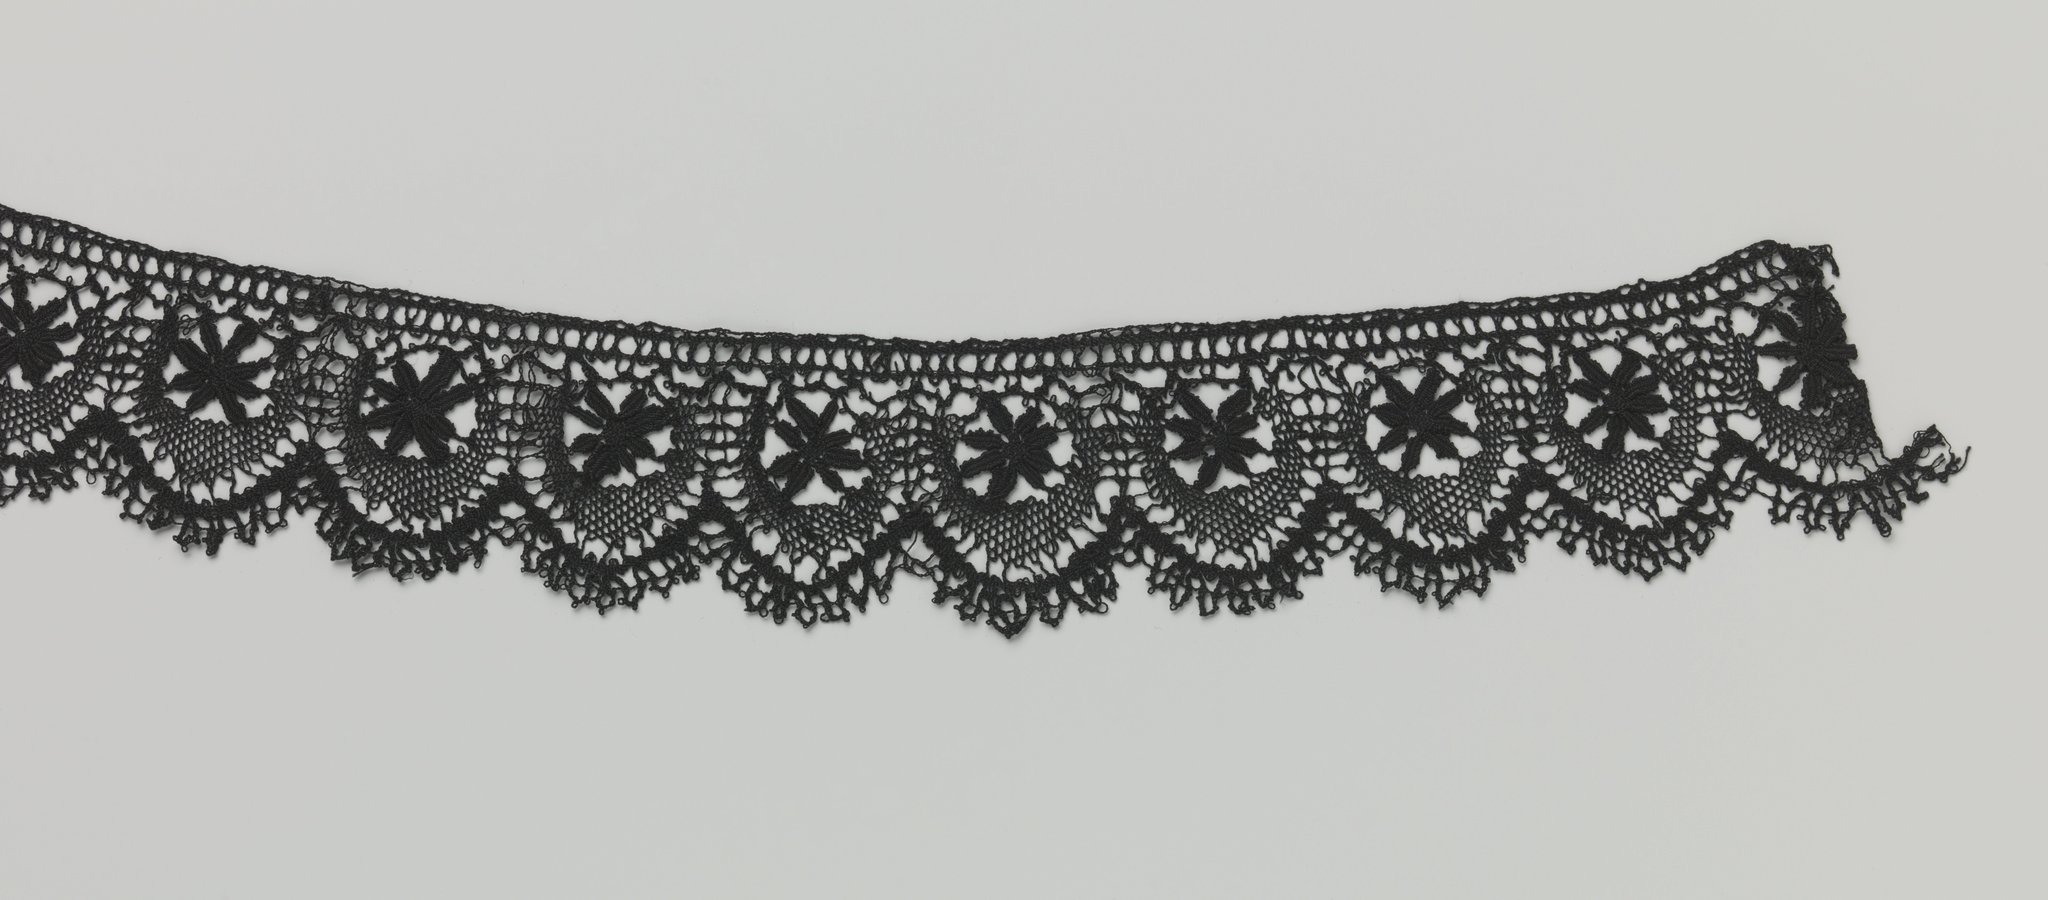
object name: strip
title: Strook kloskant met ster en halve maan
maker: Anonymous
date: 1900-1929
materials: silk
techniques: lace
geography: france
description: Strook zwarte kloskant, Cluny-kant. Symmetrisch dessin met diepe schulpen en een vlechtengrond. Elke schulp is gevuld met een achtpuntige ster die aan de onderzijde wordt omvat door een liggende halve maan. De schulpenrand is afgewerkt met boogjes en fijne puntjes van gepicoteerde vlechtjes. De bovenzijde van de strook is recht afgewerkt.